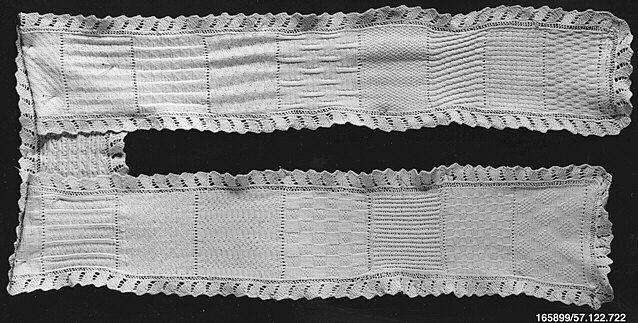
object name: sampler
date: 1801-1900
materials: lace, wool